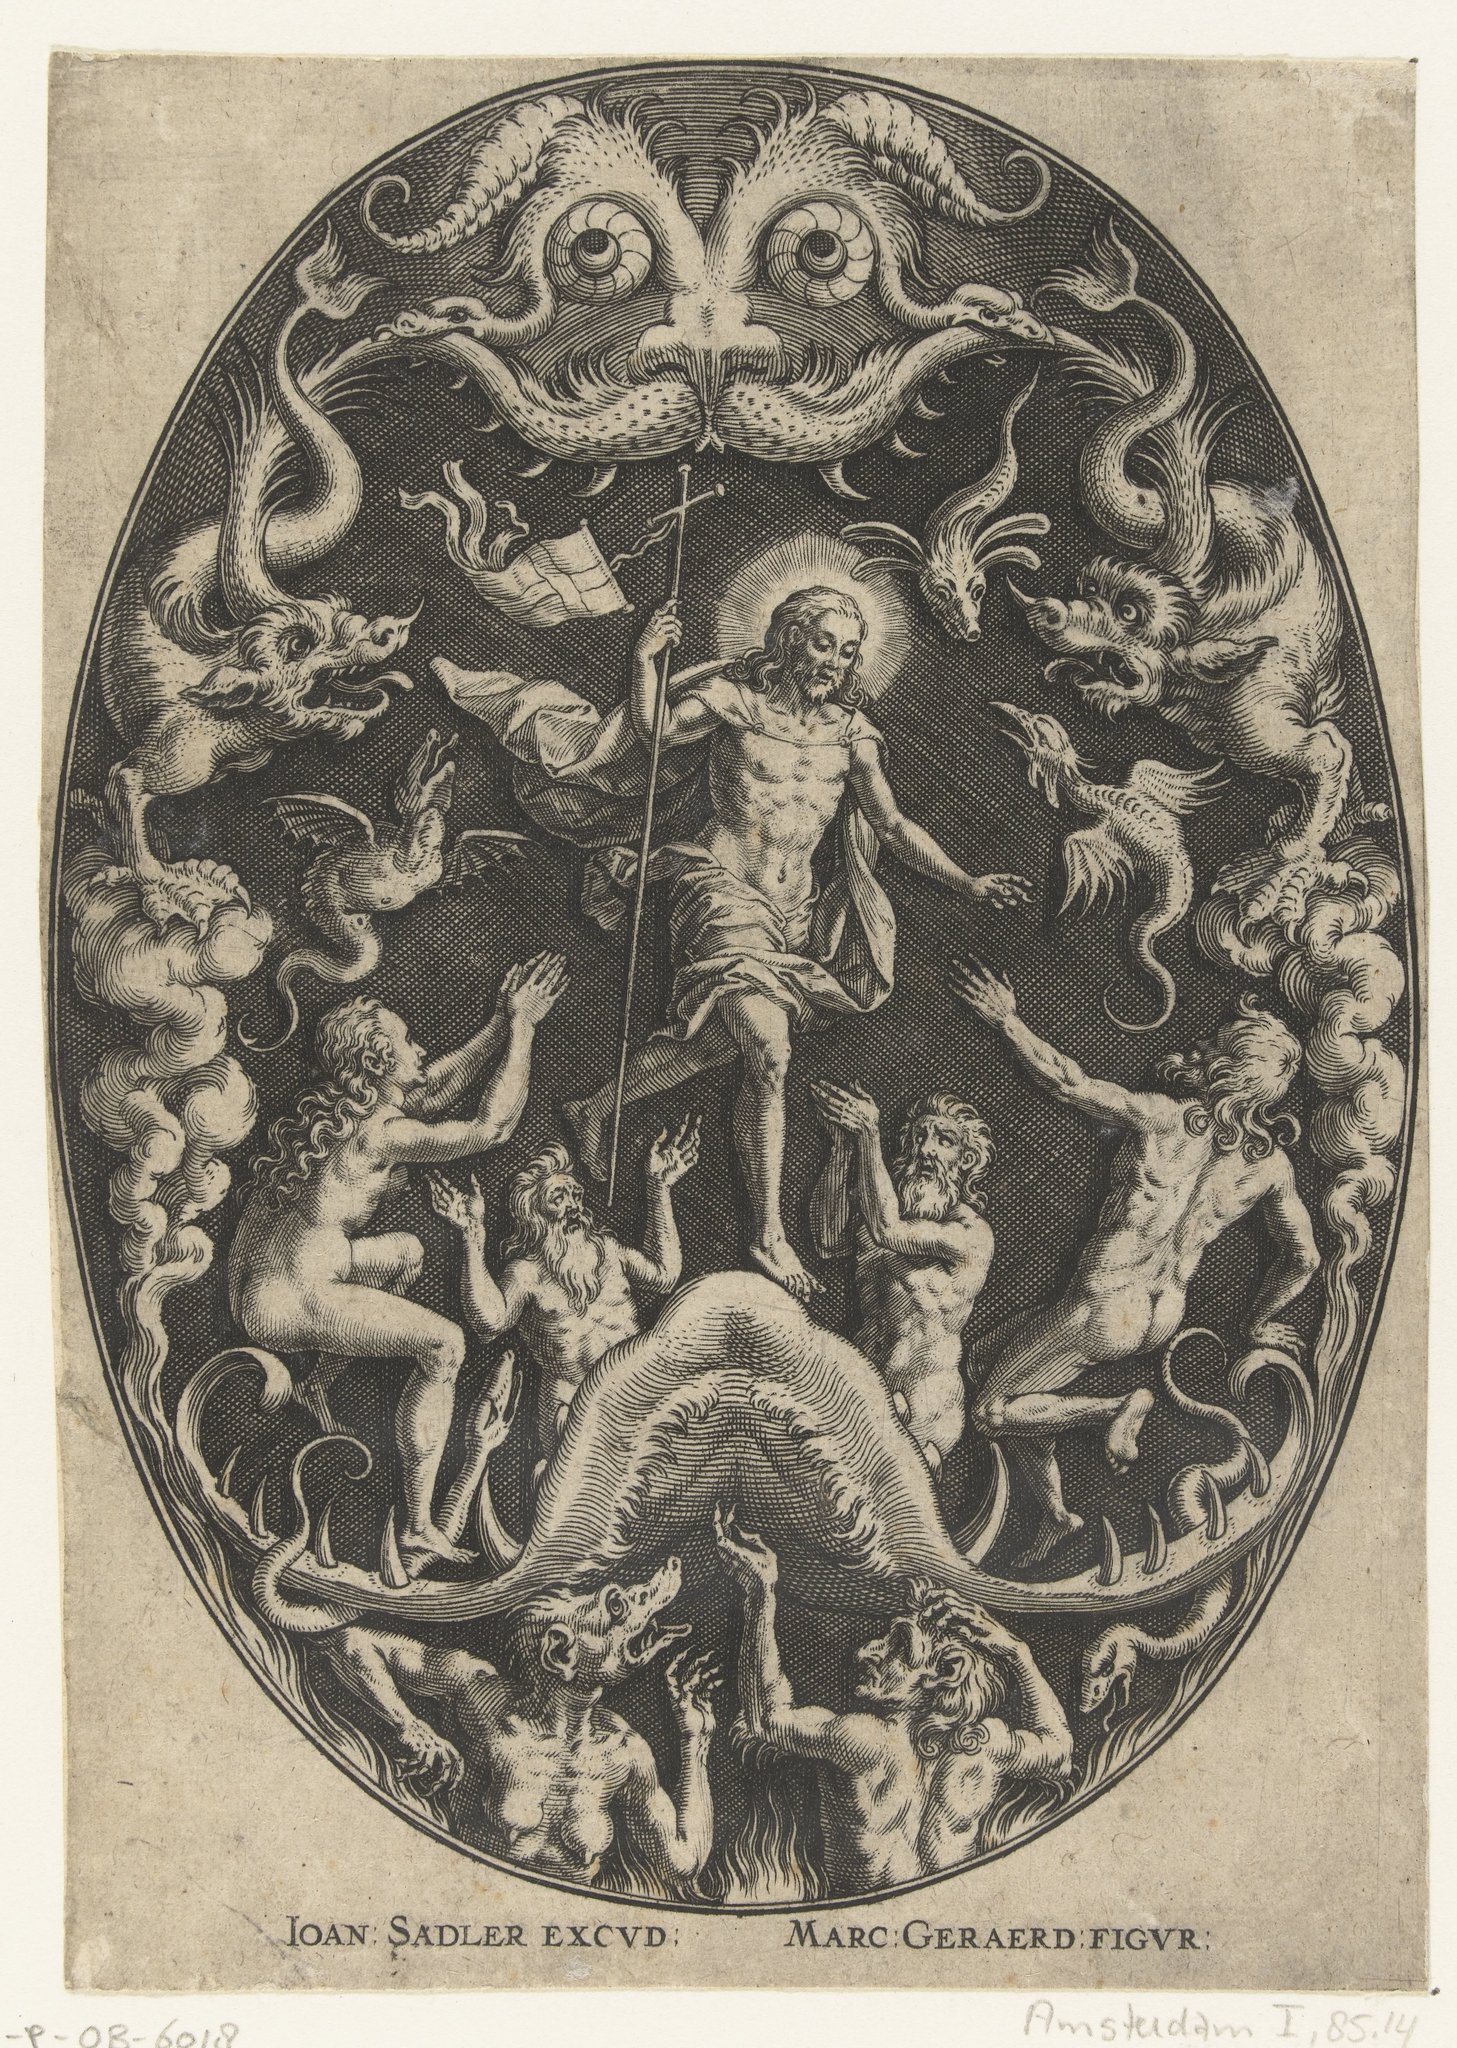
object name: ornament print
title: Christus in de hel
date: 1560-1600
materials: paper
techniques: engraving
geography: netherlands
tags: christ enters hell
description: Uit serie van 14 ovalen met grotesken waarin scènes uit de passie zijn afgebeeld. Gearceerde achtergrond.